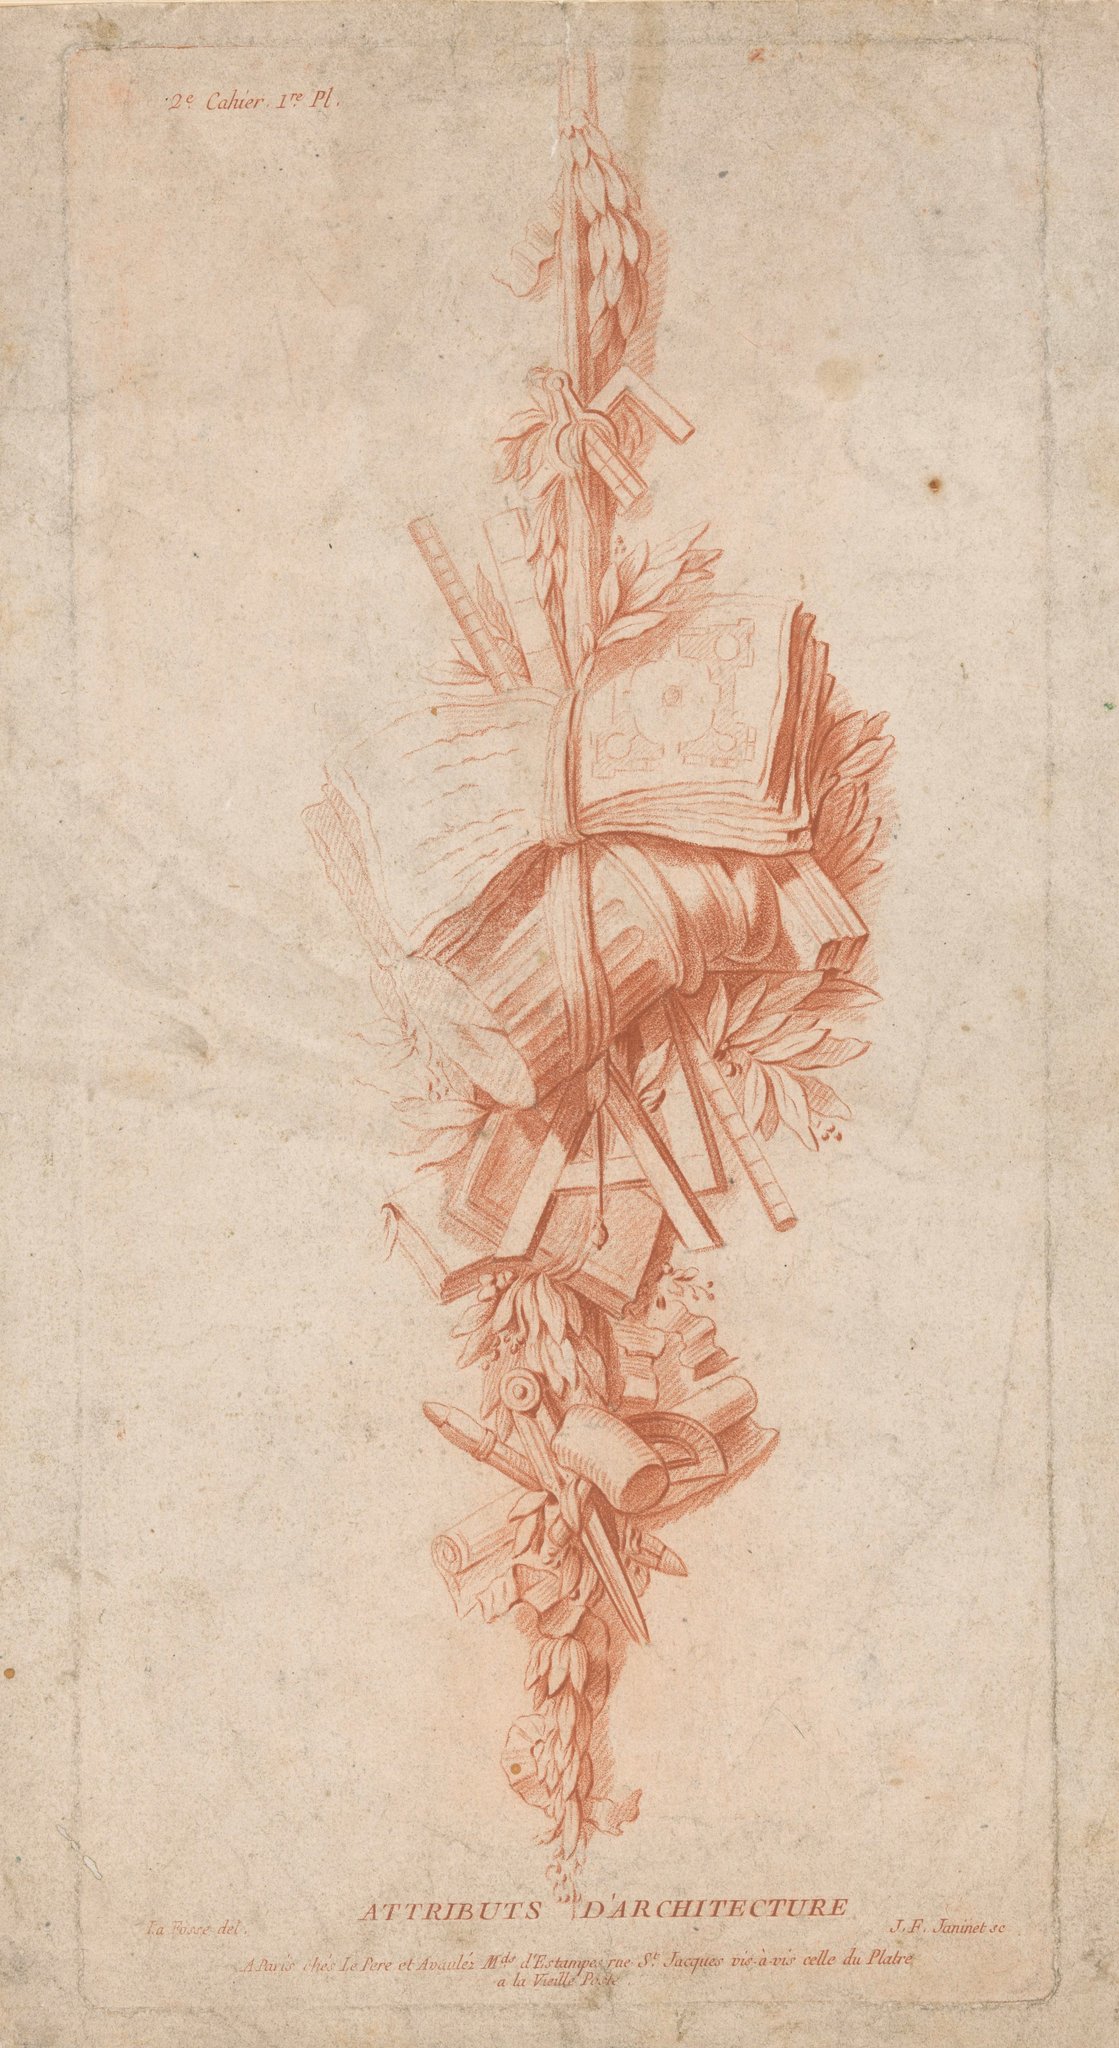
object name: ornament print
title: Trofeeën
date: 1772-1779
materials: paper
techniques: printmaking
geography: paris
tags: trophy, i.e.: decorative arrangement of symbolic or typical objects ~ ornament, architecture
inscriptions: collector's mark: Lugt 2760, collector's mark: Lugt 2228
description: Een trofee met attributen behorende bij architectuur zoals schetsen, een deel van een zuil, een winkelhaak en een passer.